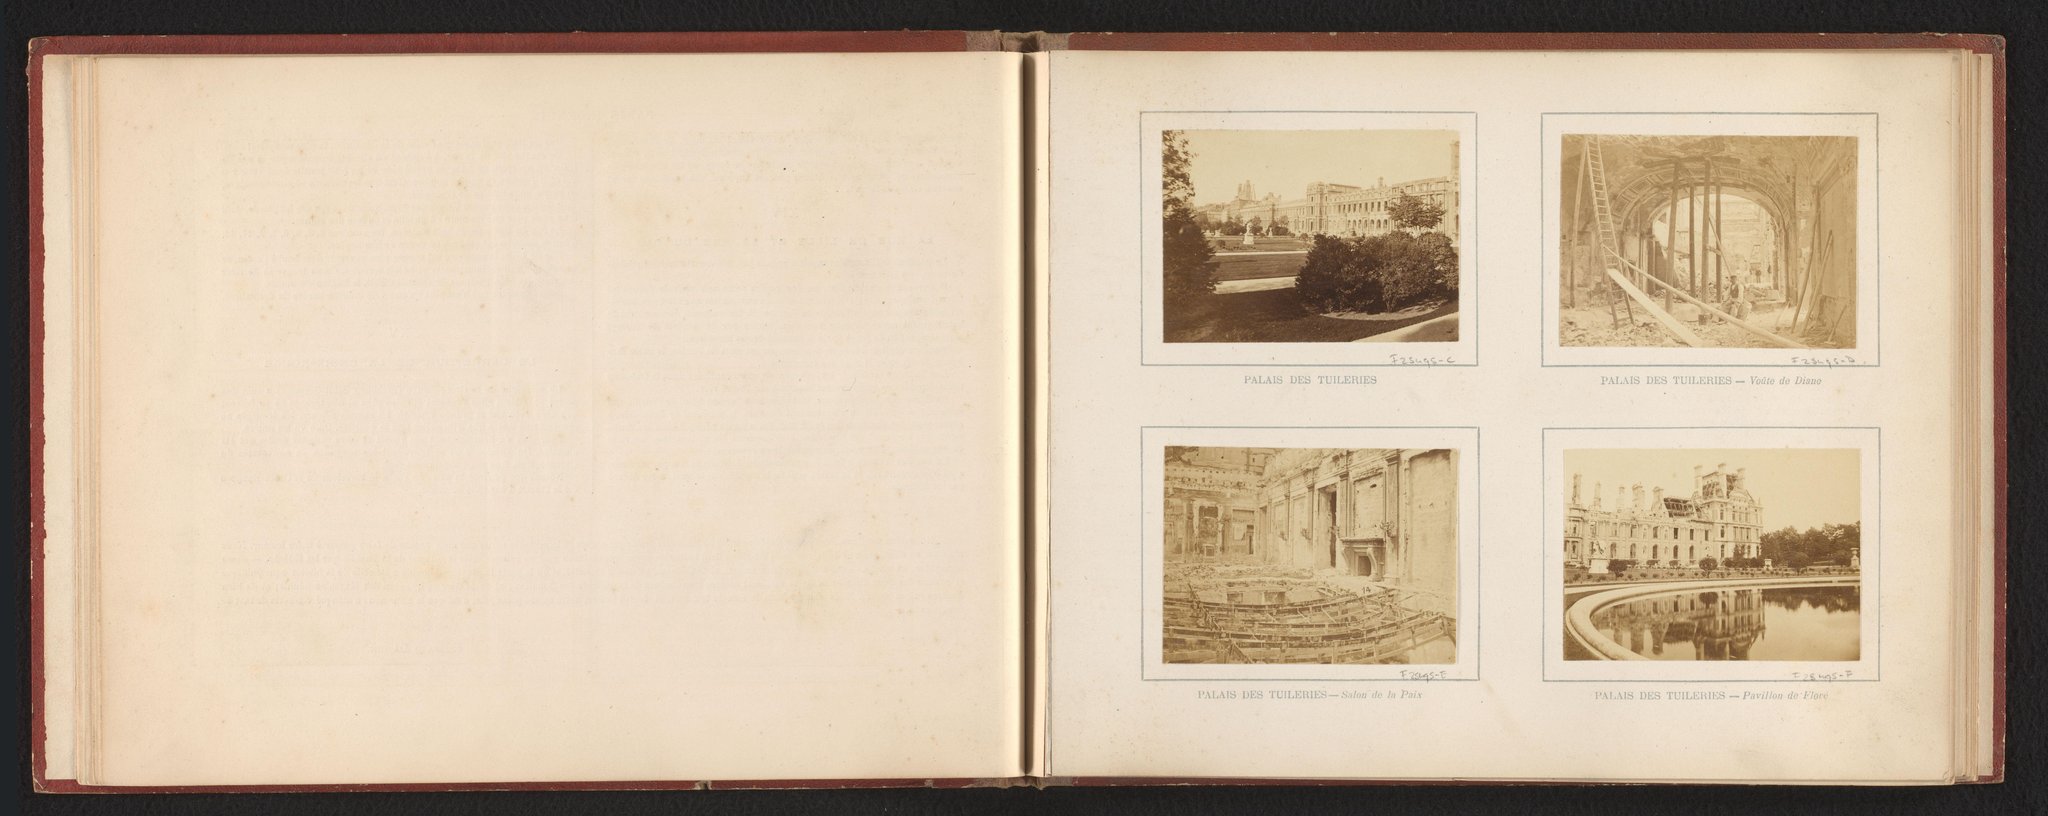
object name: photograph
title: Gezicht in het verwoeste Tuilerieënpaleis in Parijs na de semaine sanglante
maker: Anonymous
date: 1871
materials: paper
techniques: albumen print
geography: paris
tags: ruin of a building ~ architecture, tuileries palace